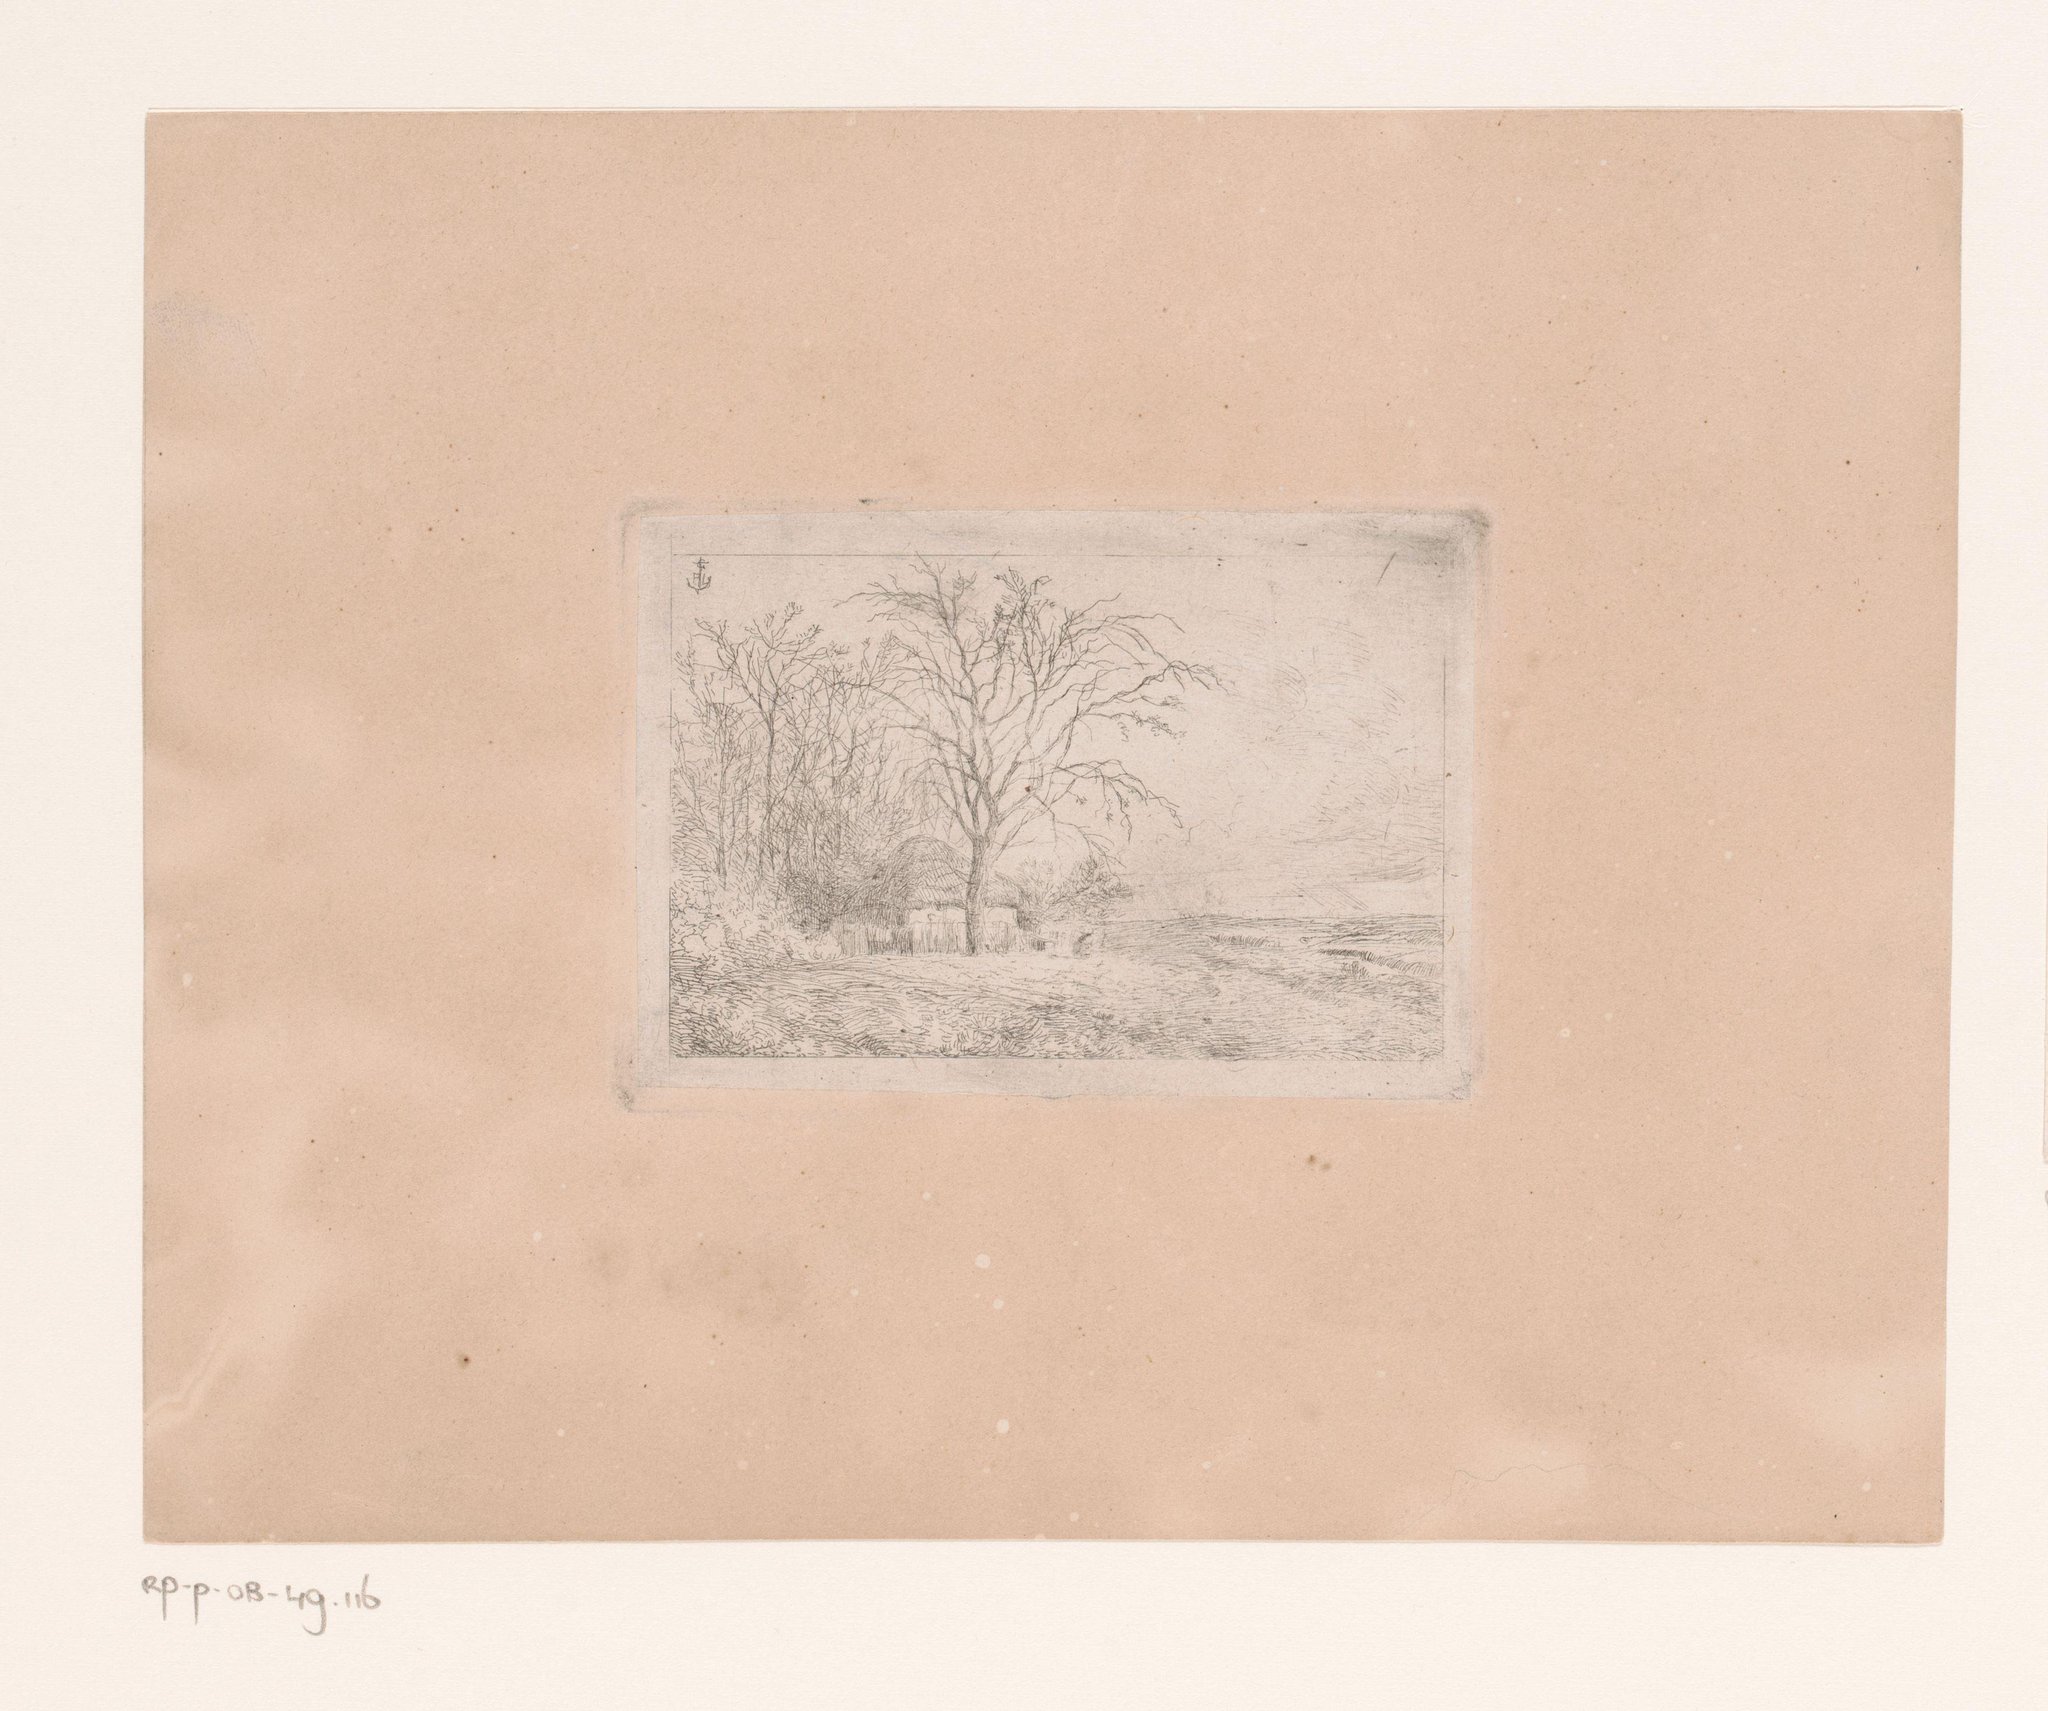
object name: print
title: Landschap met een klein gebouw tussen kale bomen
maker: paulus lauters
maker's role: print maker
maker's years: 1806-1875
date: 1816-1875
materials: paper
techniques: etching, intaglio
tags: trees, farm or solitary house in landscape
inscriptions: collector's mark: Lugt 2228